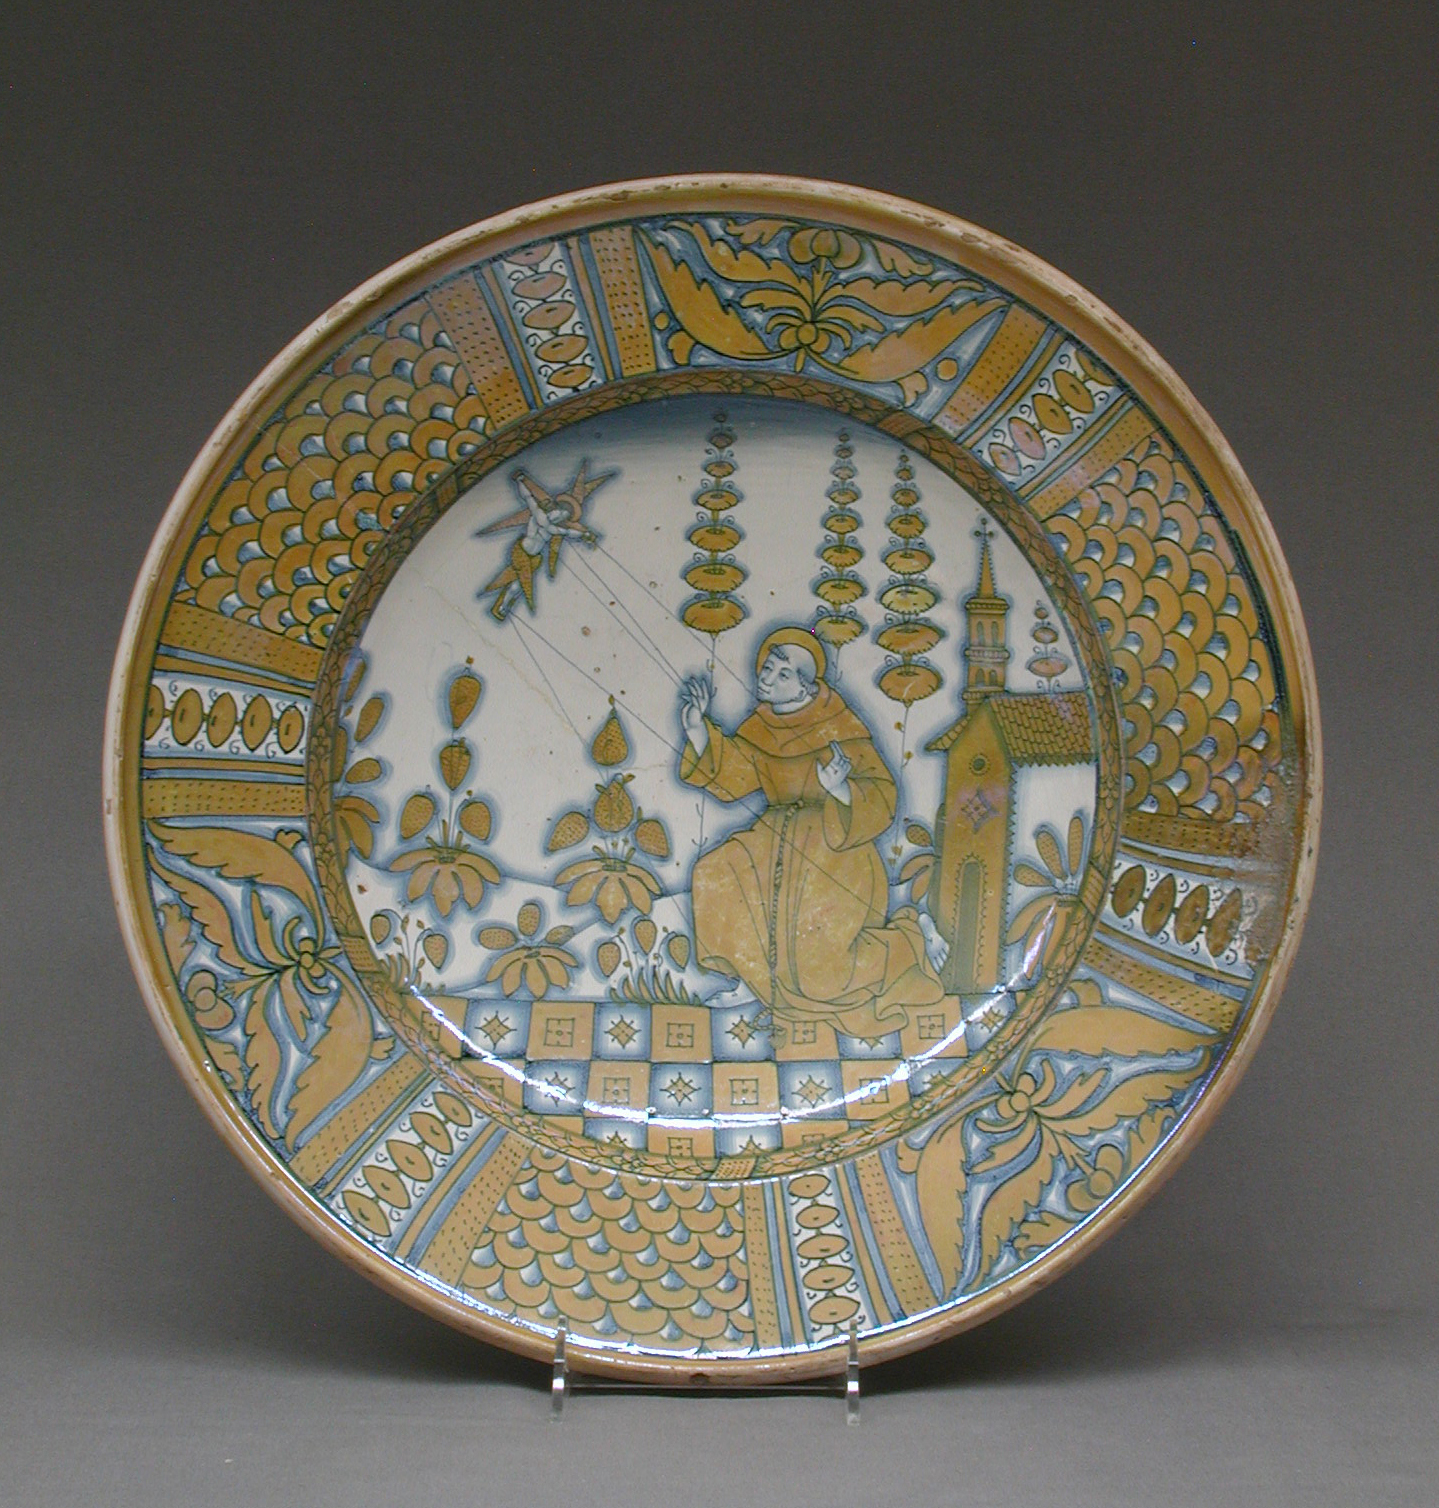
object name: plateau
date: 1520-1525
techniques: maiolica, glazing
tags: men,saint francis,crucifixion